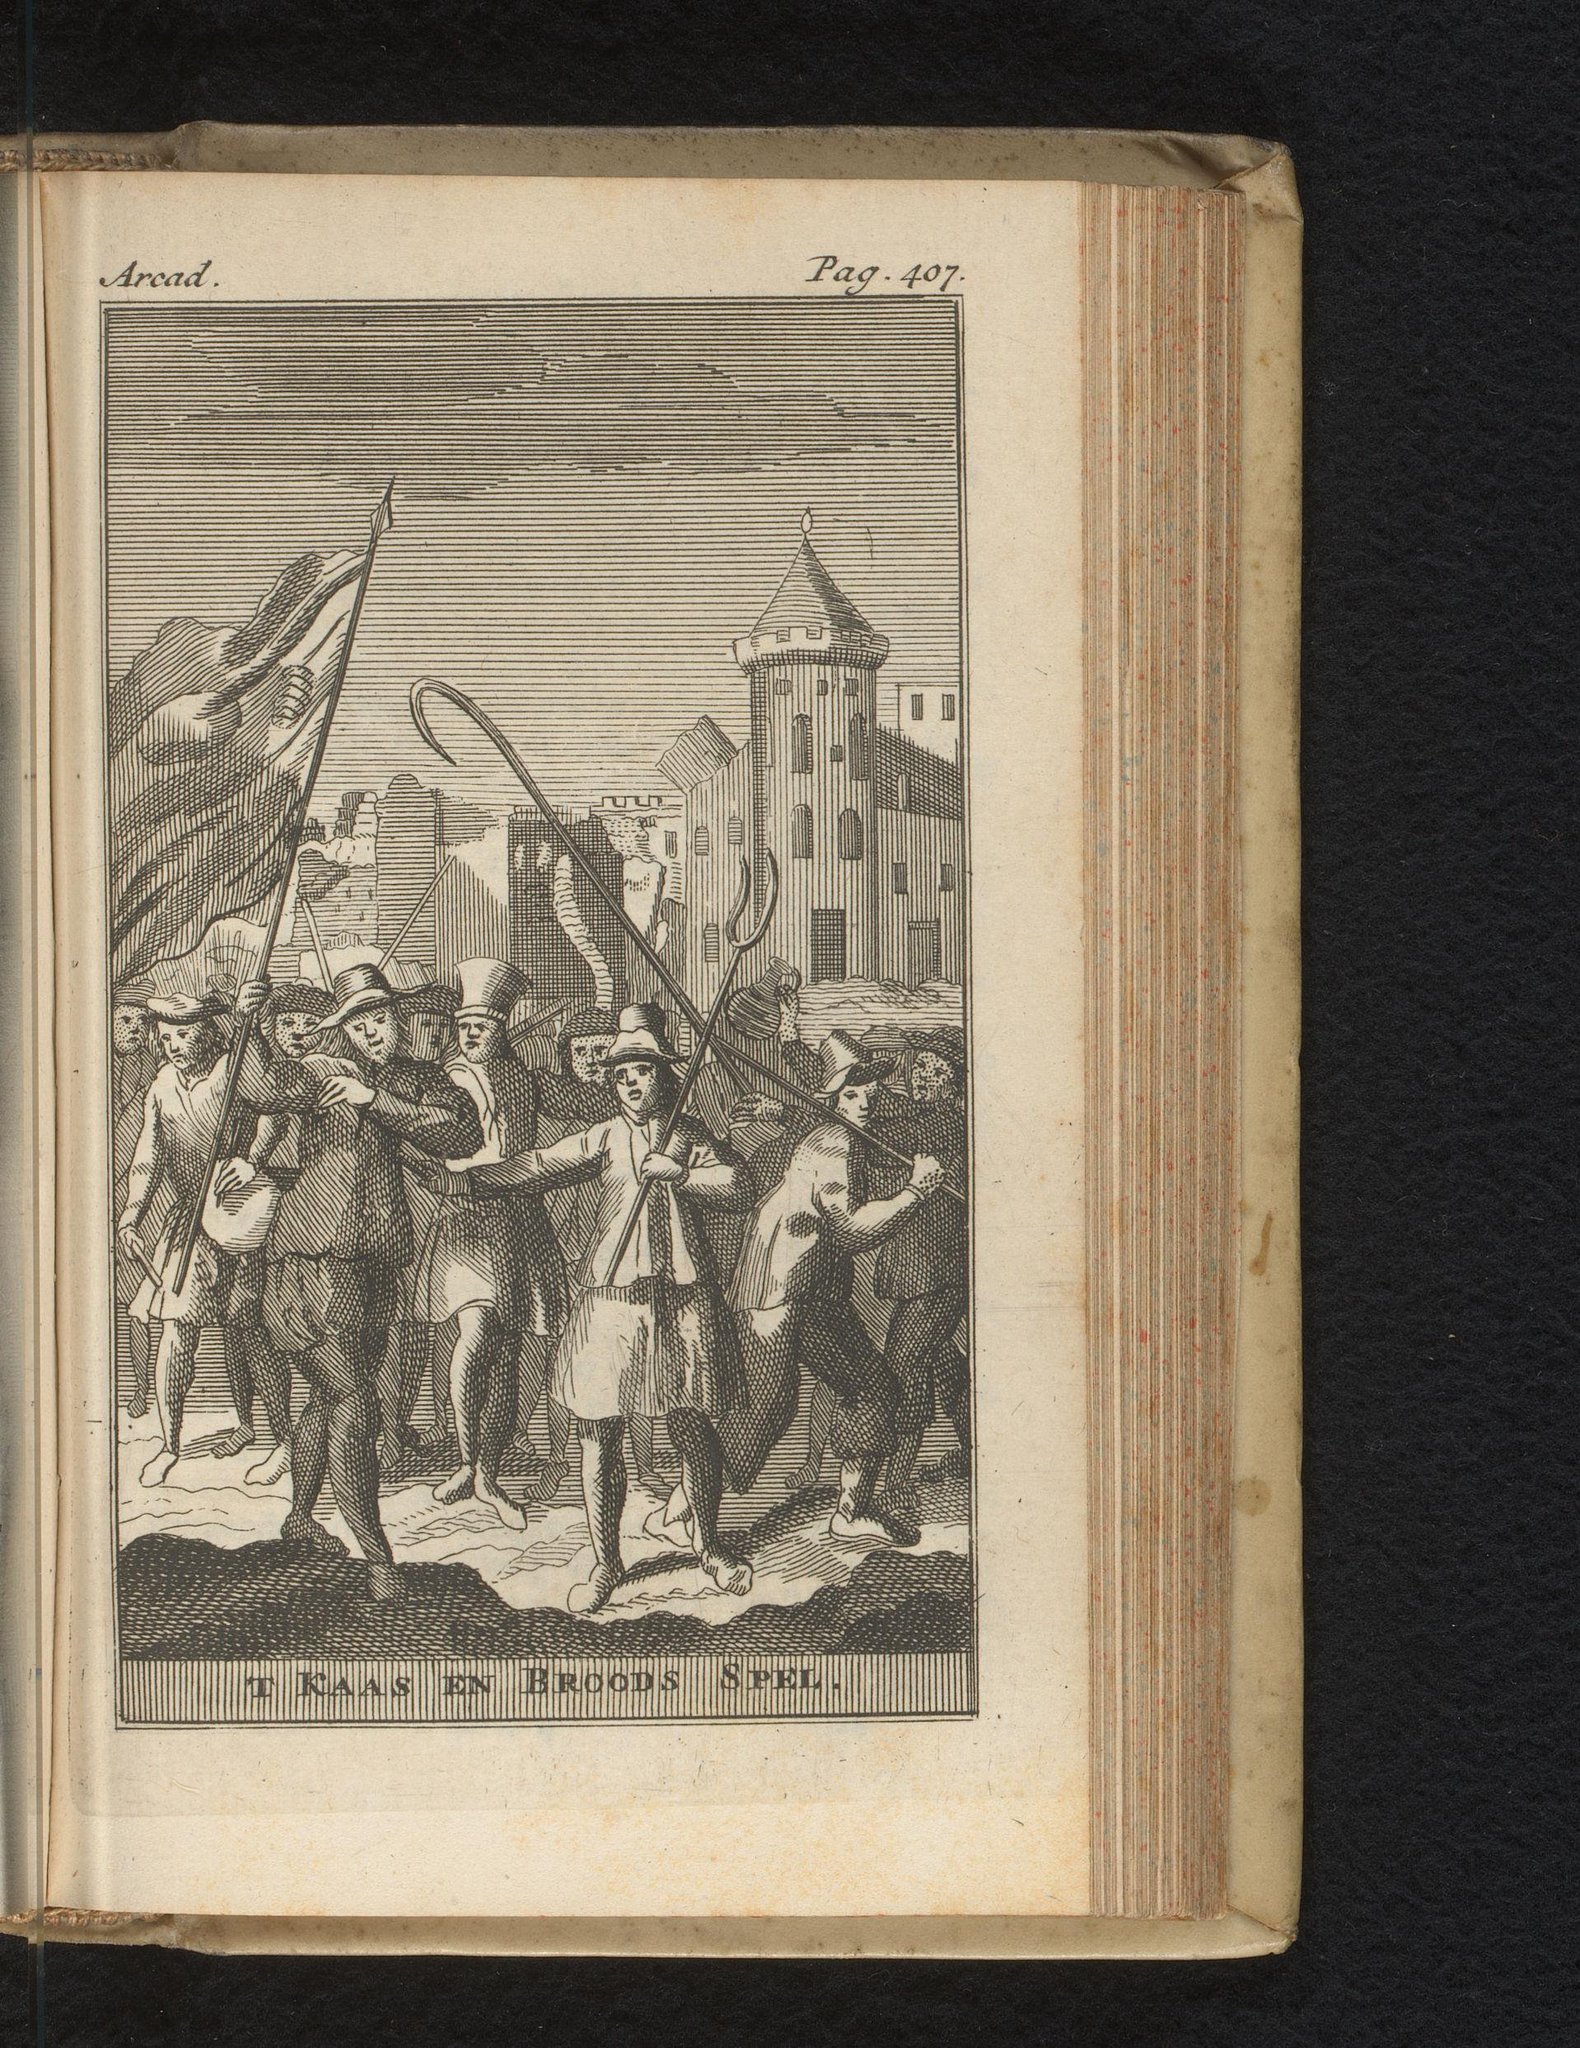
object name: history print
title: Opstand van het Kaas- en Broodvolk, 1492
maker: pieter van den berge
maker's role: draughtsman, print maker, printer, publisher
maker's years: 1659-1737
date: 1700-1702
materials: paper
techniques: engraving, etching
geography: northern netherlands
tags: street-fights, riots, netherlands, burgundian netherlands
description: Illustratie in: H. Soeteboom, Oud-heden van Zaan-land, Stavoren, Vronen en Waterland : deze laatste druk ... met nodige aanteekeningen, figuren, en een landkaart verrykt / Saan-Landse Arcadia, W. Linnig van Koppenol, Amsterdam 1702, dl. 1, ingebonden tussen p. 406/407.